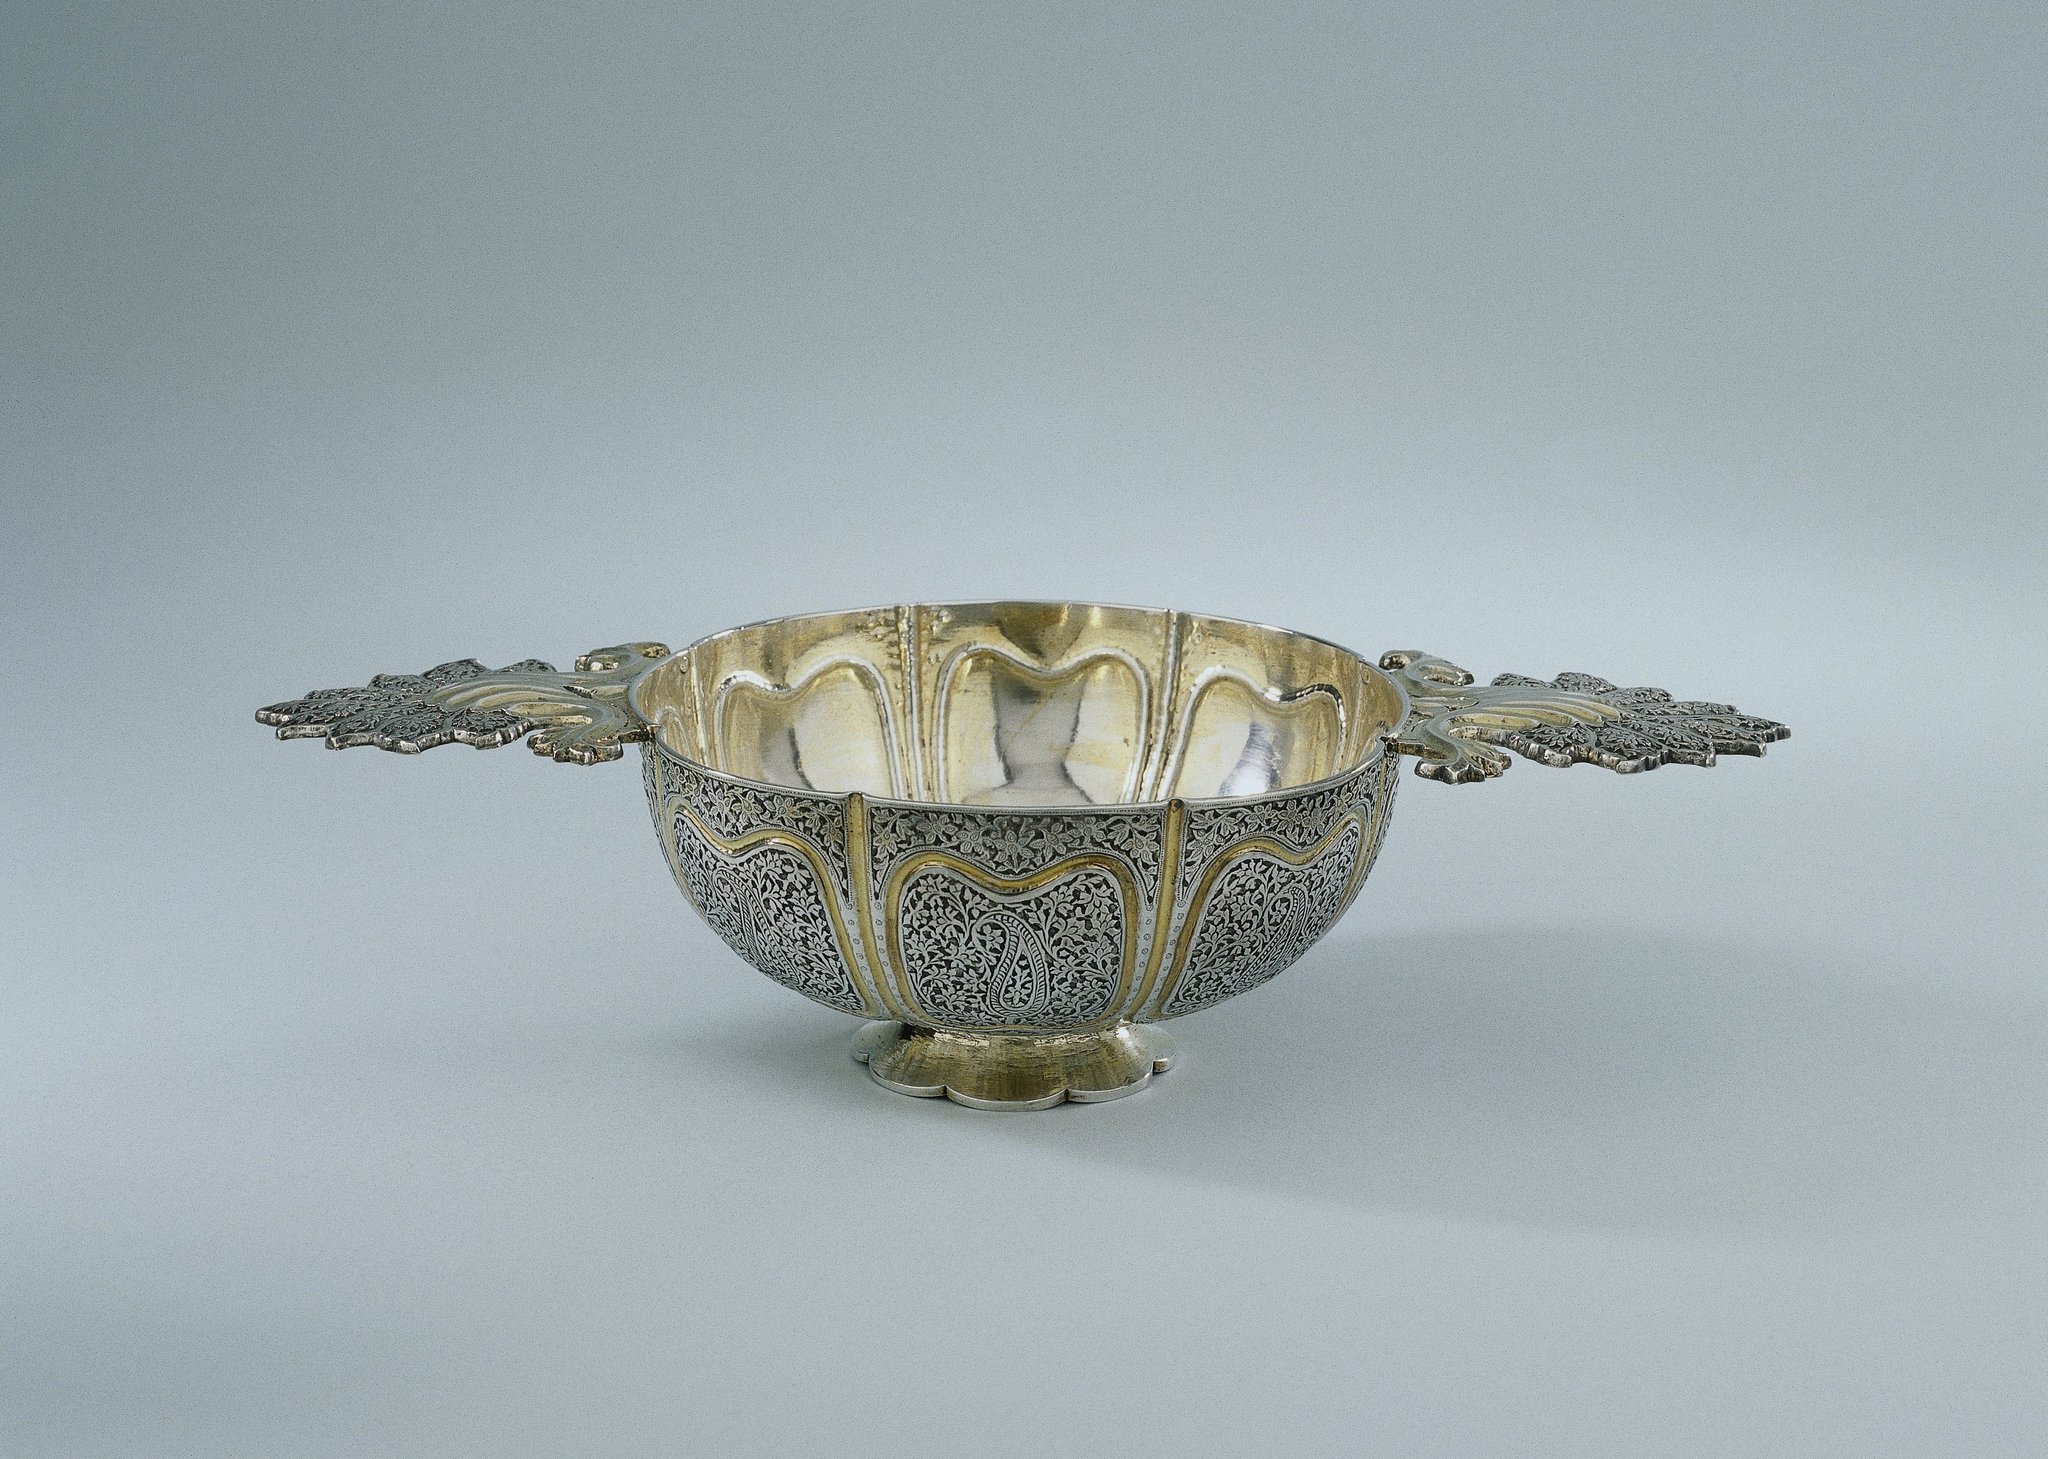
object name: brandy bowl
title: Brandewijnskom van verguld zilver met bloem- en bladrankversiering in Indonesische trant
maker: Anonymous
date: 1700-1749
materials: silver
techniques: gilding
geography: batavia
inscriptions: mark: ‘merken: M in vierkant (Batavia); mt: NS in rechterhoek.’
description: Brandy bowl. Silver, partly gilded. Indonesia, 1700 - 1750. Purchased from Stichting Cultuurgeschiedenis Nederlanders Overzee.